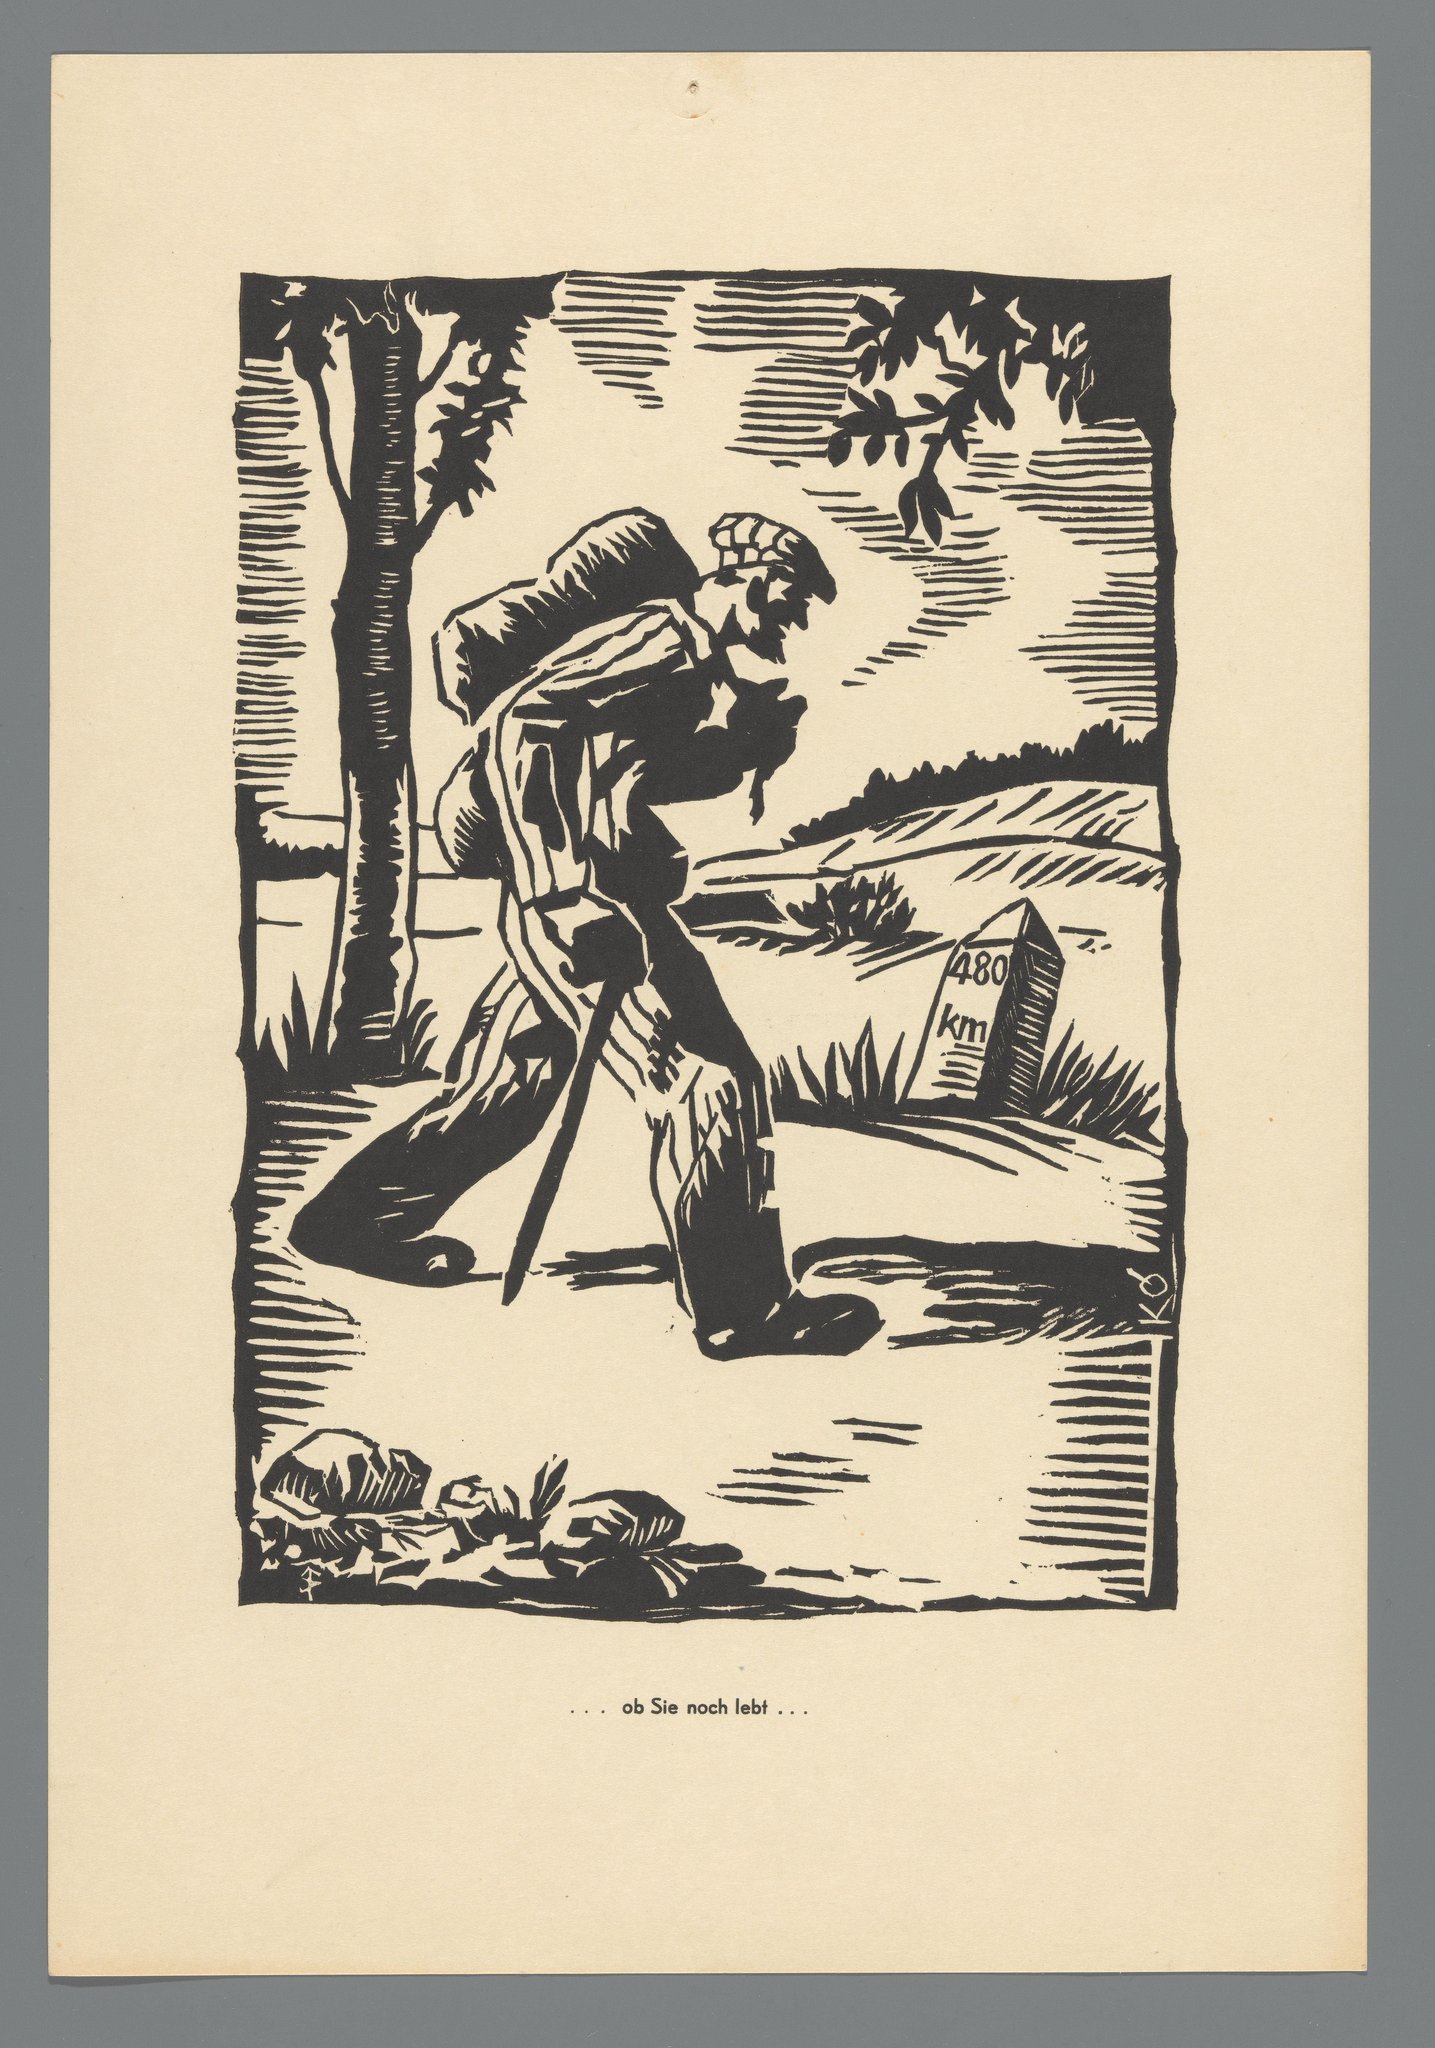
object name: print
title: ... ob Sie noch lebt ...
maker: monogrammist ko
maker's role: print maker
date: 1918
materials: paper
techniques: linocut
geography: germany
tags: after the battle, return of the soldiers to civilian life, returning home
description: Een man in een gestreept pak met een zak op de rug, onderweg naar huis lopend, hij moet nog 480 km.